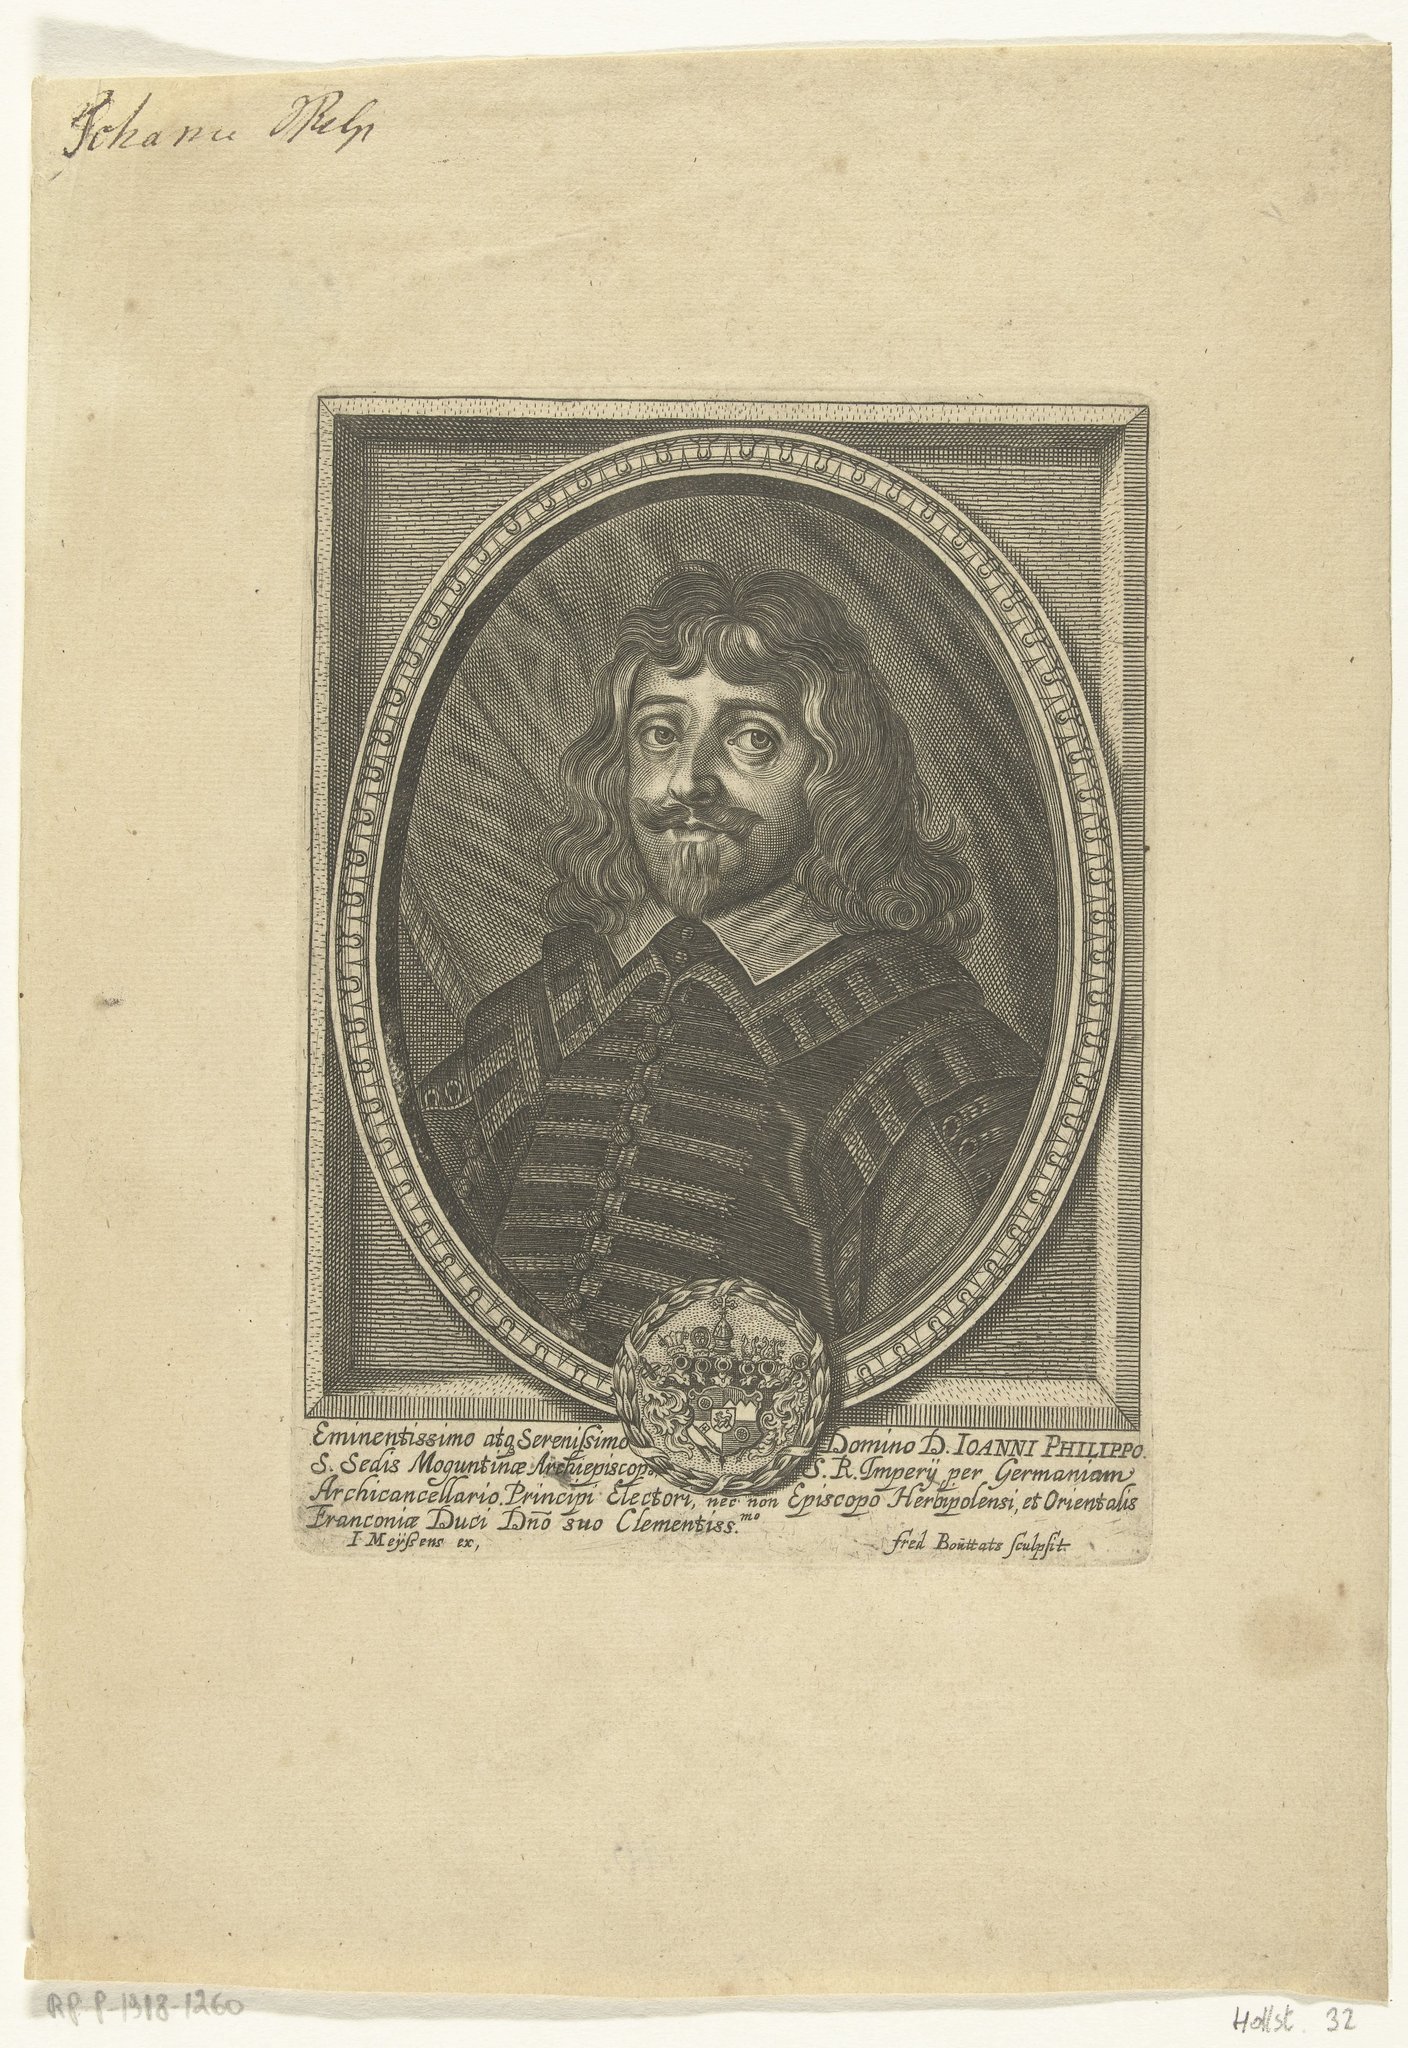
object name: print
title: Portret van Johann Philipp von Schönborn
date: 1647-1661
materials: paper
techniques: engraving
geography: antwerp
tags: würzburg, bisschop, johann philipp von schönborn (aartsbisschop van mainz)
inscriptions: inscription: ‘Johann Pilp’, collector's mark: Lugt 2233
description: Portret in een ovale lijst van Johann Philipp von Schönborn, aartsbisschop van Mainz, bisschop of Würzburg en bisschop van Worms. Buste naar links. De prent heeft een Latijns onderschrift met de naam van de geportretteerde.